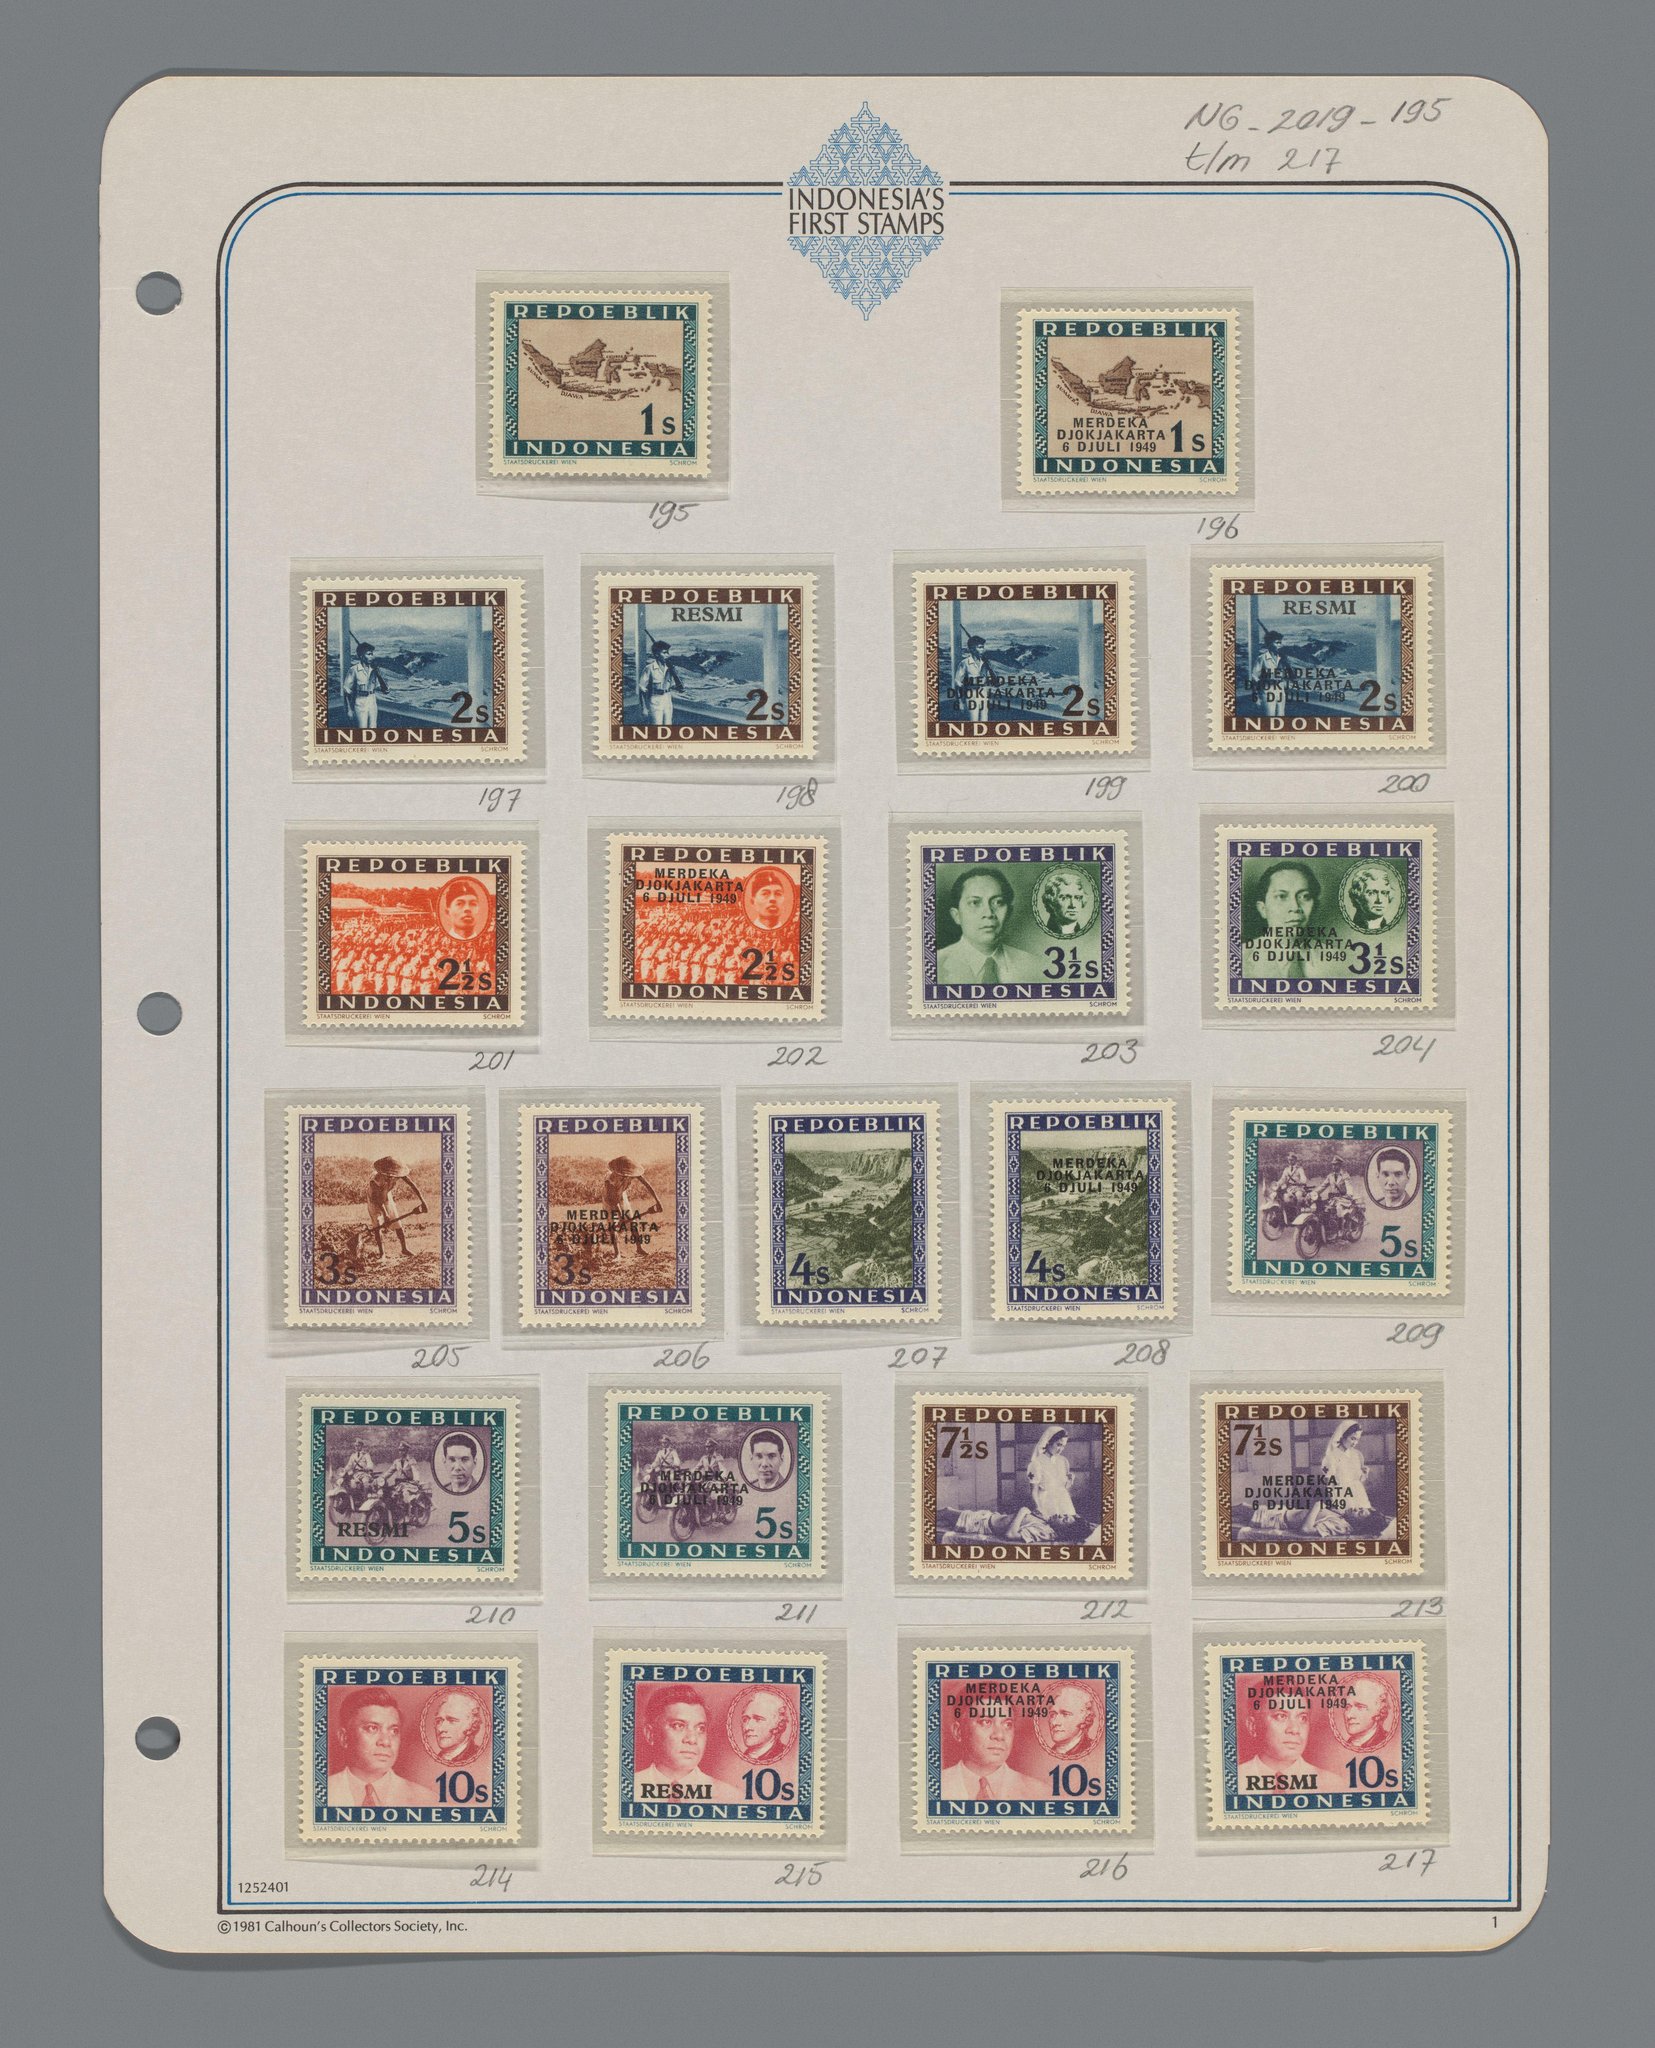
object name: postage stamp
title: Postzegel Republik Indonesia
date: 1949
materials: paper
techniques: photoaquatint, engraving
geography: vienna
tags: indonesia